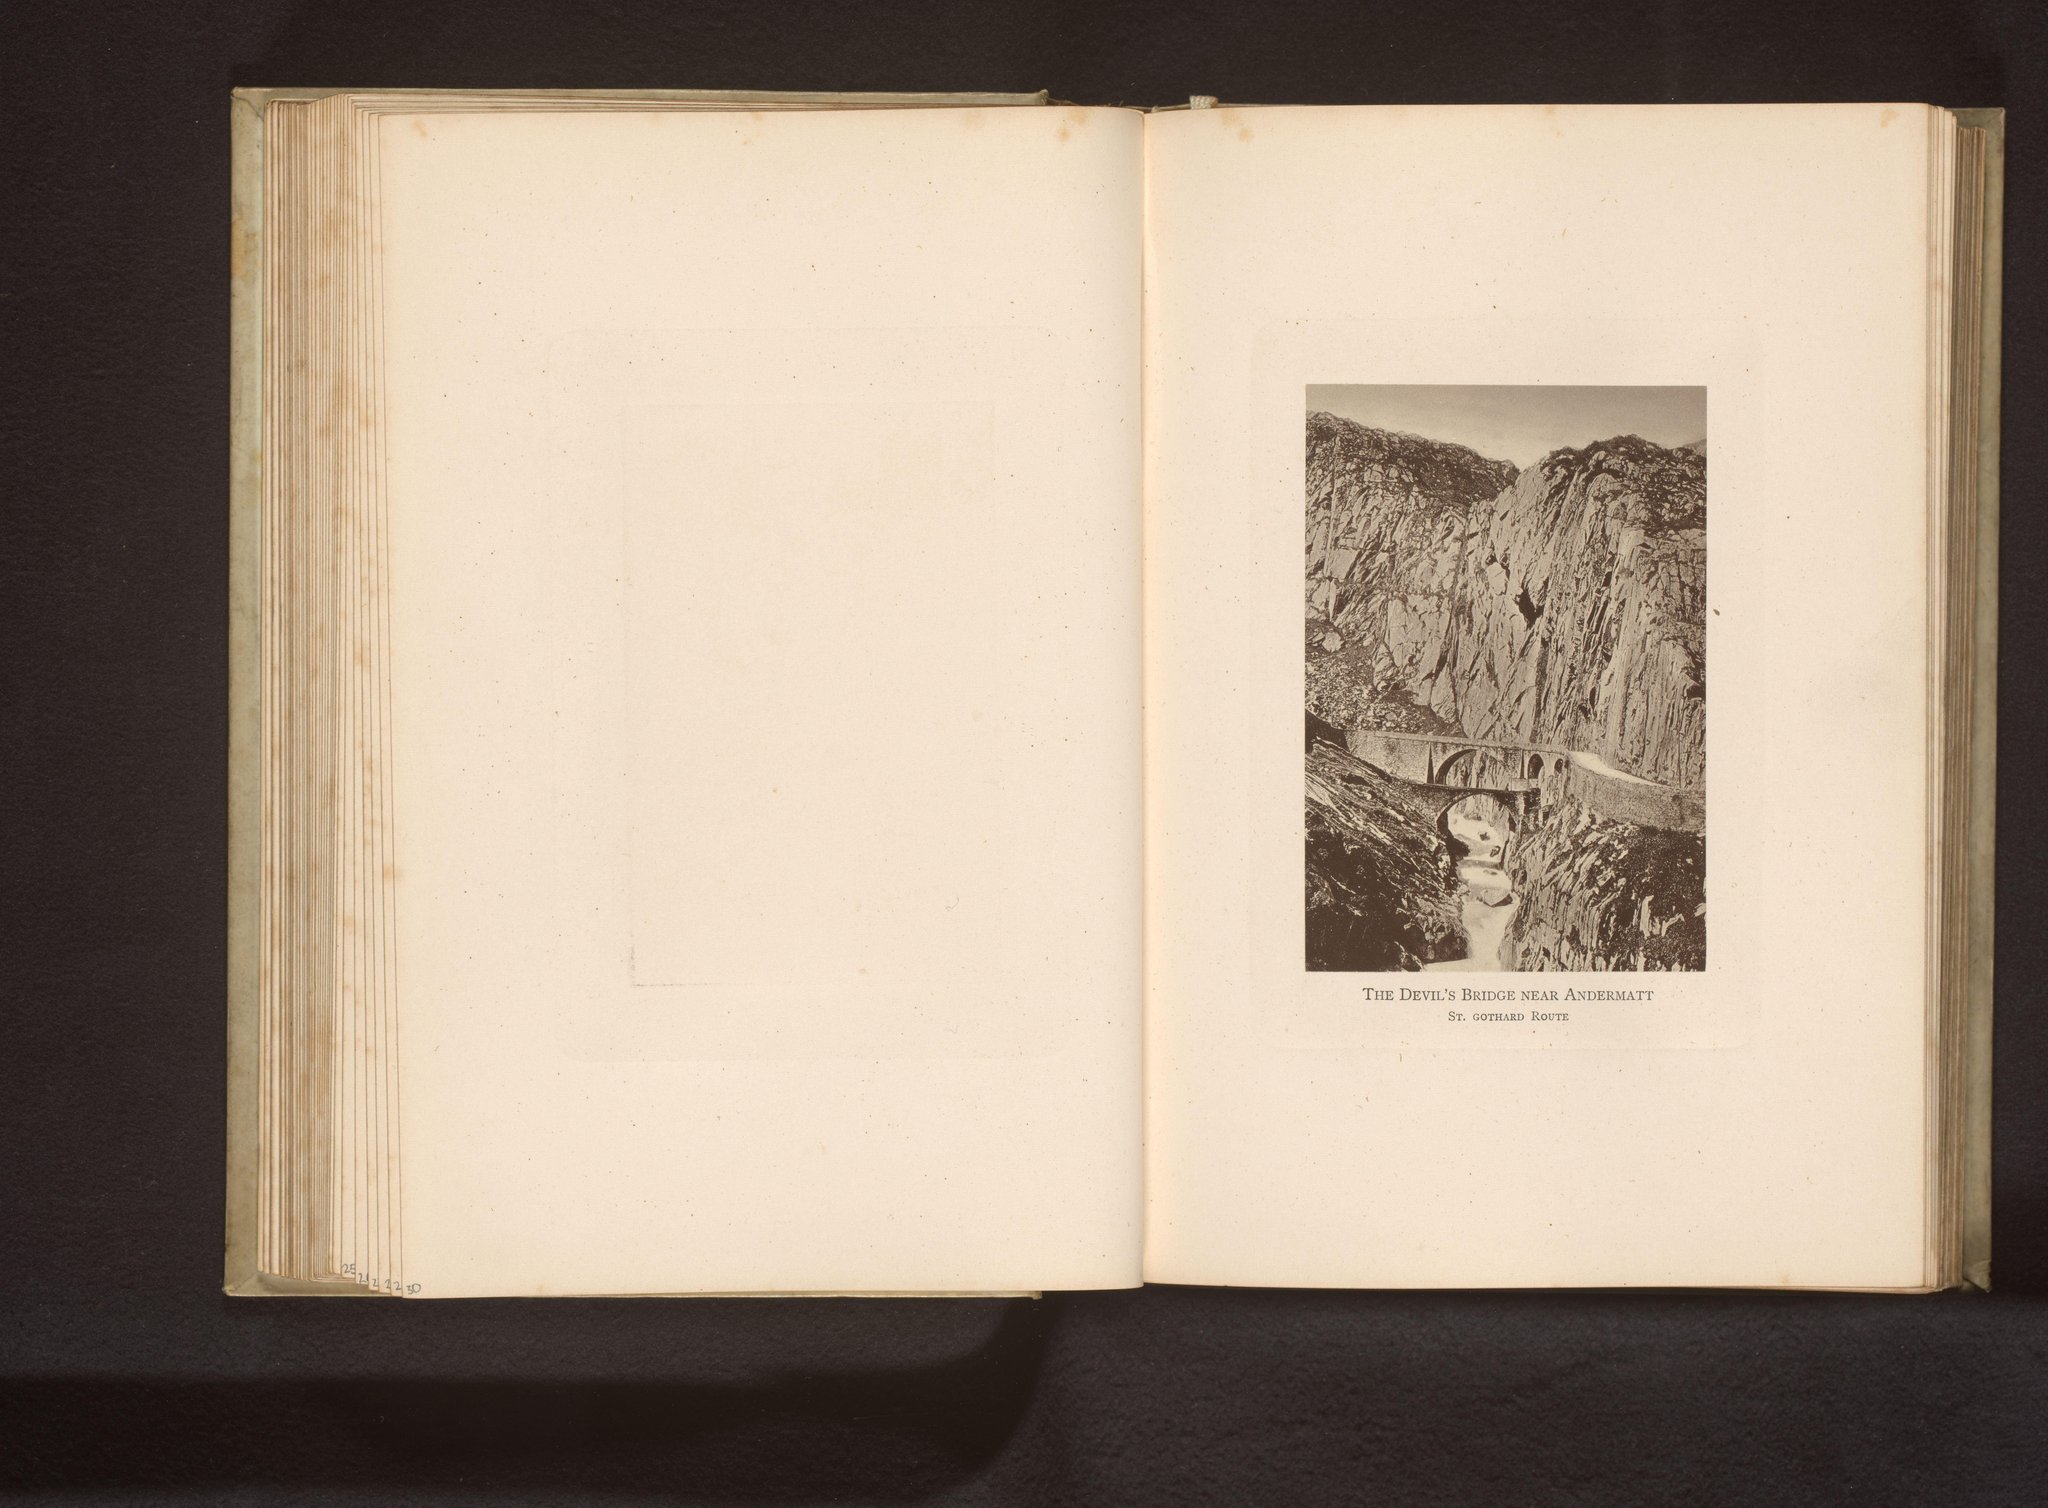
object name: page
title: Gezicht op de Teufelsbrücke bij Andermatt in Zwitserland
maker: Anonymous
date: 1874-1884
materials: paper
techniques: photograph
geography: switzerland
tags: bridge, mountains, switzerland